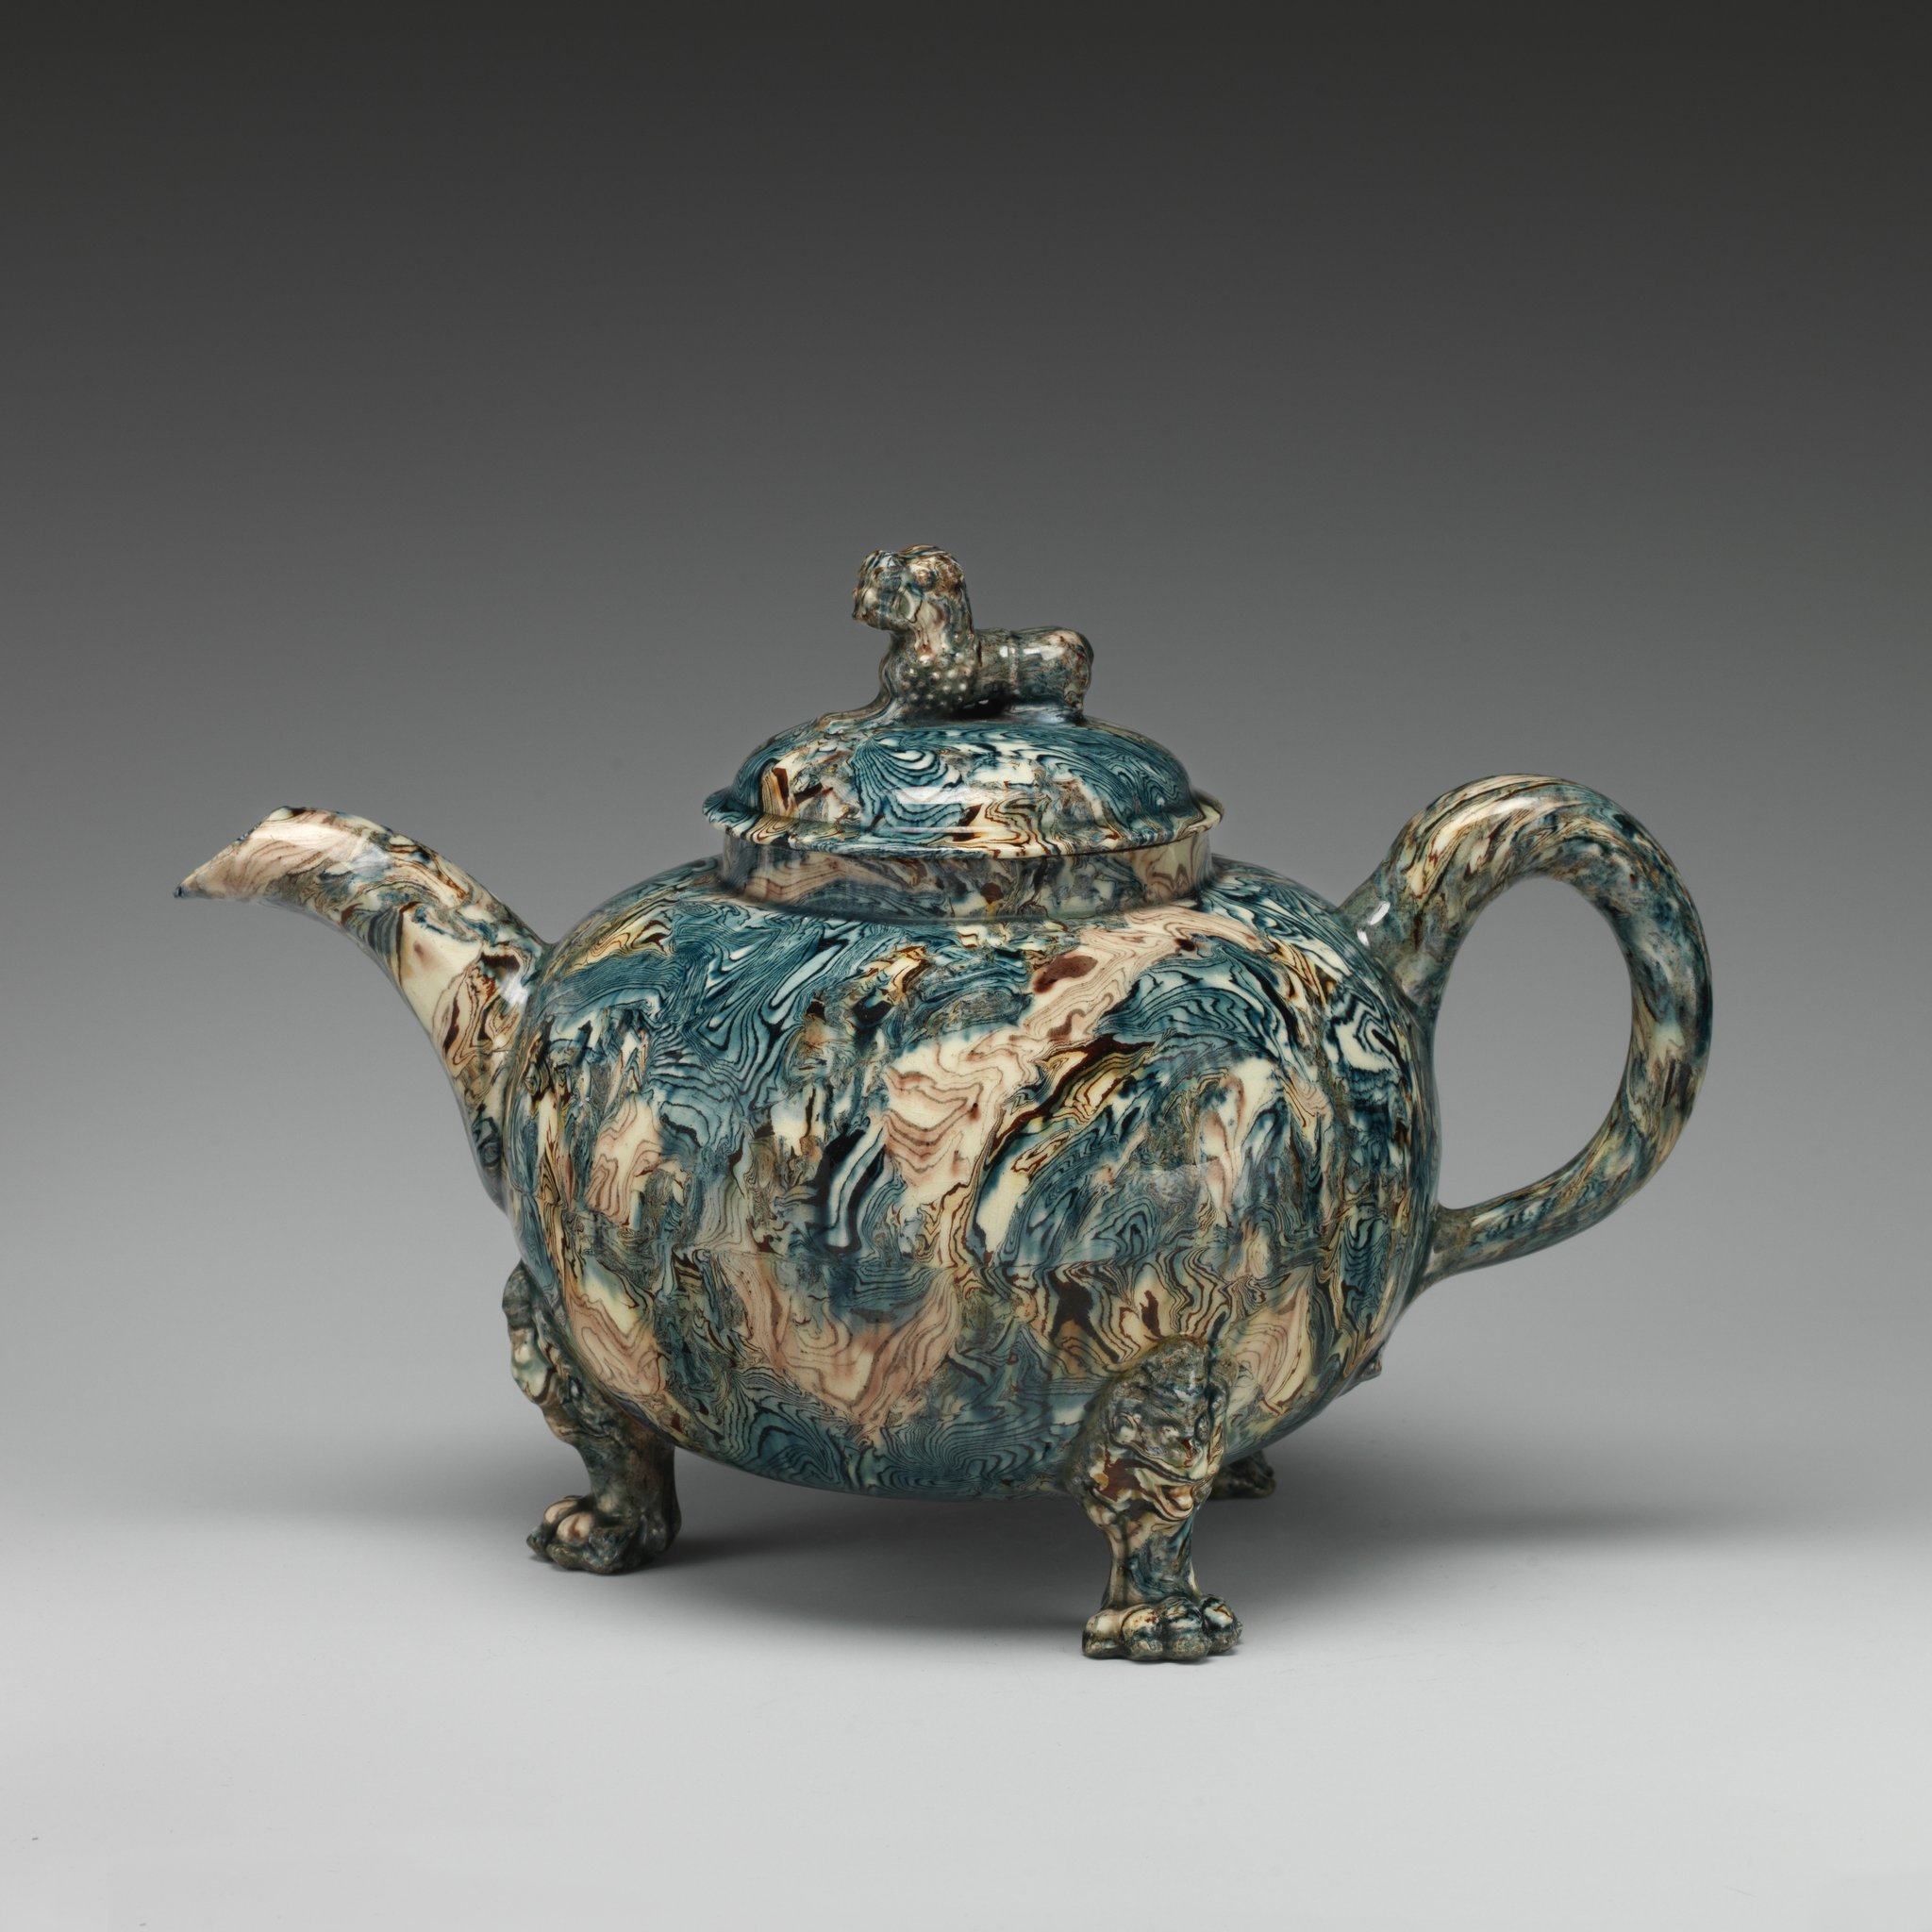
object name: teapot with cover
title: Footed teapot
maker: whieldon type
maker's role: maker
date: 1750-1765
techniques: glazing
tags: animals